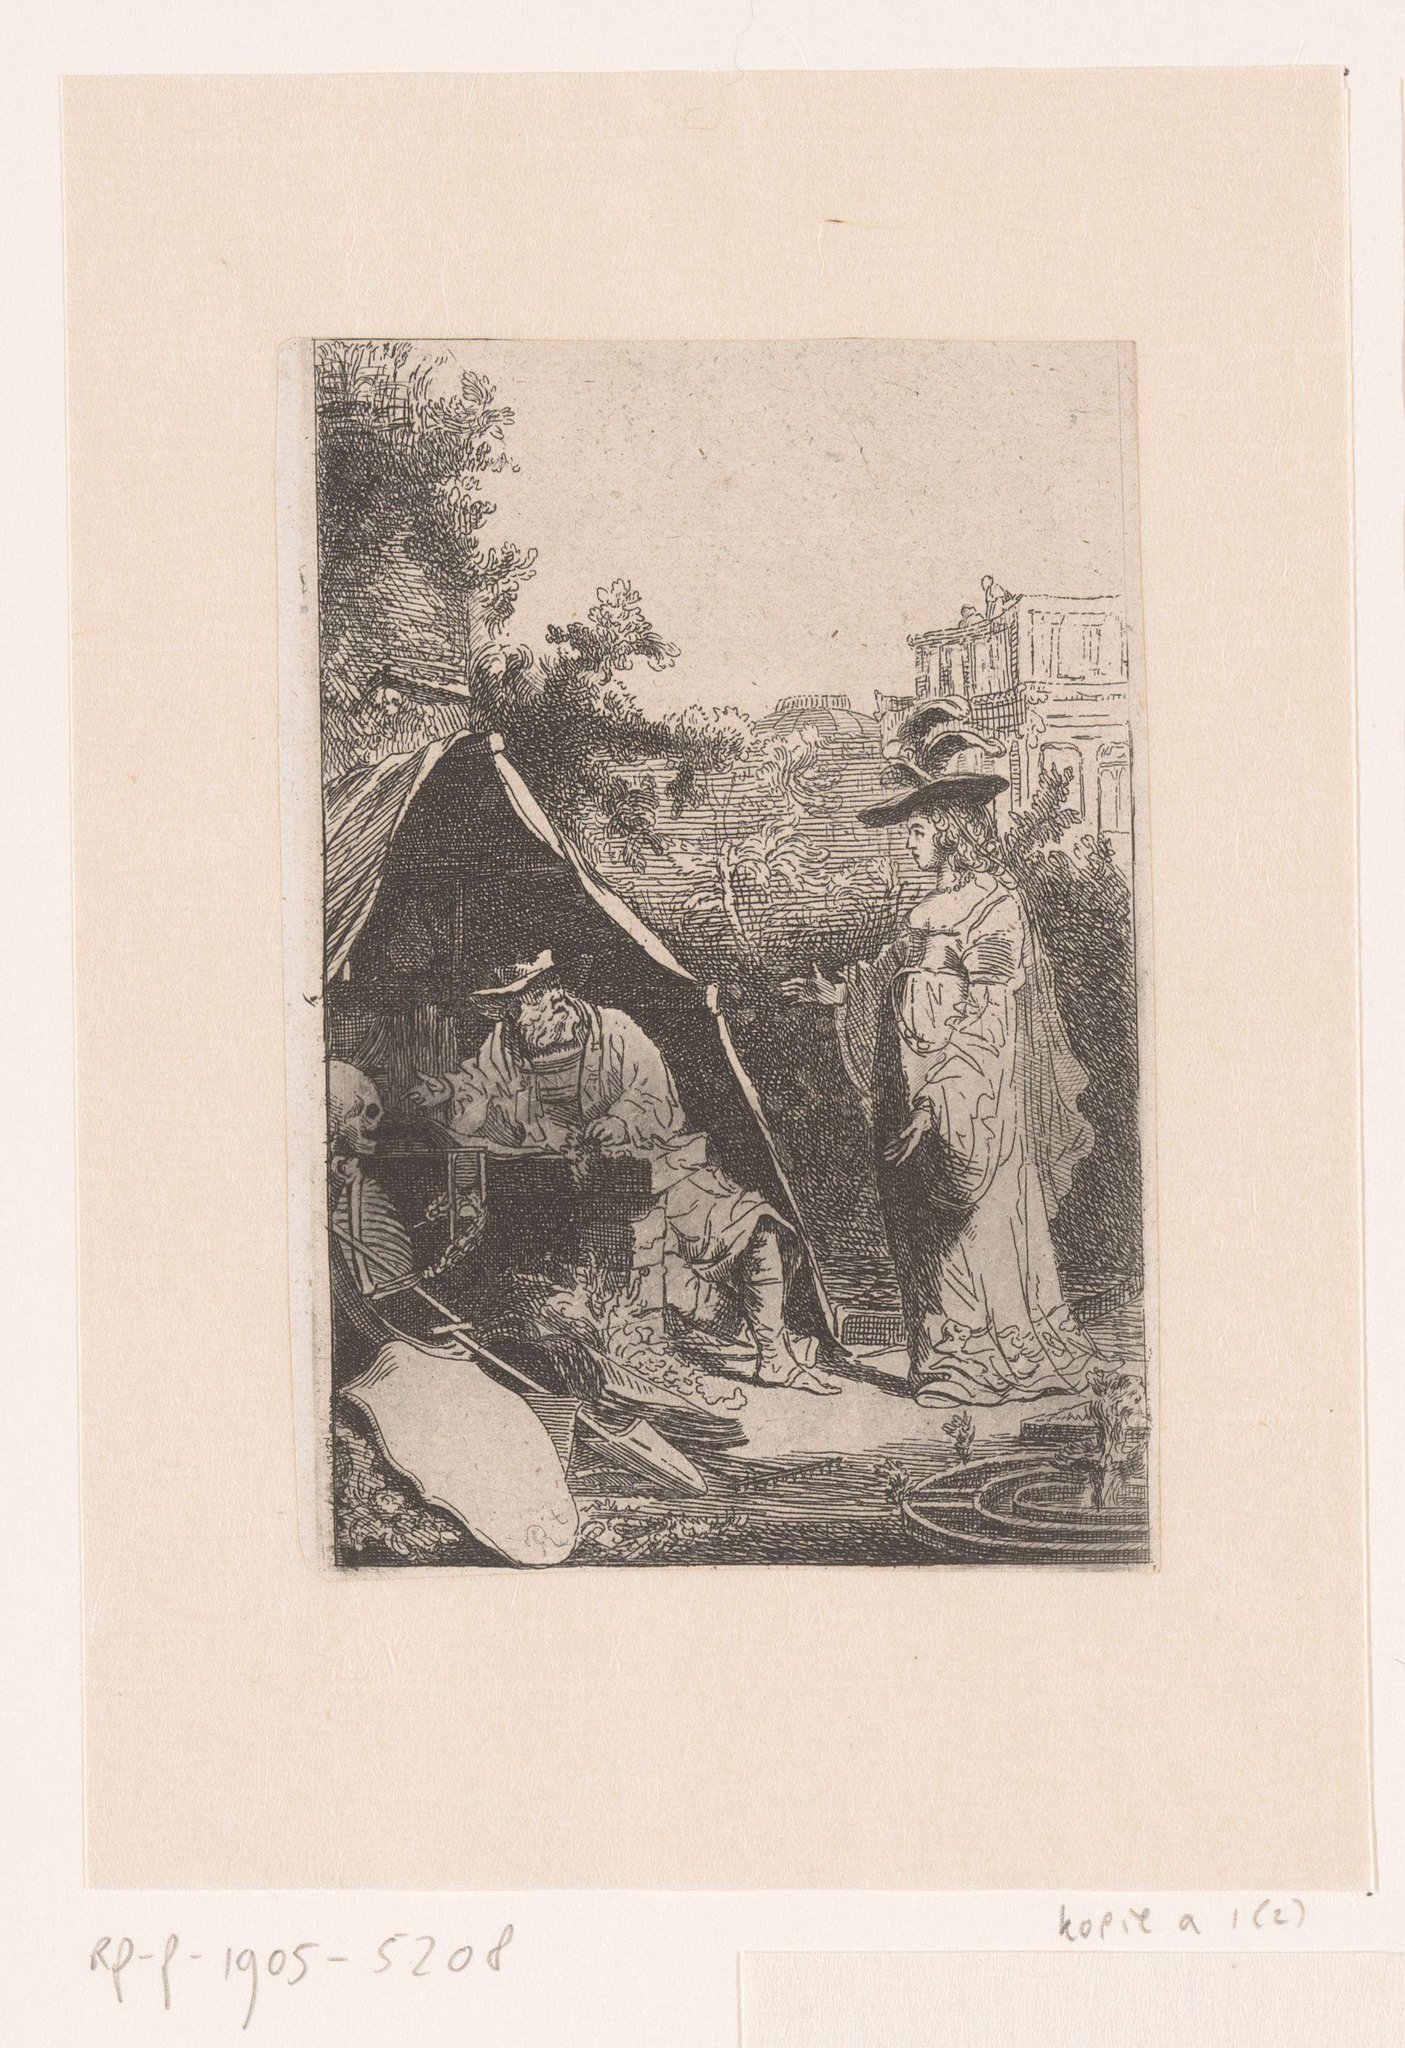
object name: print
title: Jonge vrouw en oude man met De Dood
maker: james hazard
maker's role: print maker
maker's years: 1748-1787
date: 1758-1787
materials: paper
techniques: etching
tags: dance of death; death together with one or more human beings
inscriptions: collector's mark: Lugt 2028, collector's mark: Lugt 2228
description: Prent voor het eerst gebruikt in: Recueil de Quatre-Vingt-Cinq estampes originales, têtes, paysages et différens sujets, dessinées et gravées par Rembrandt. Parijs: Henry Louis Basan, 1819.